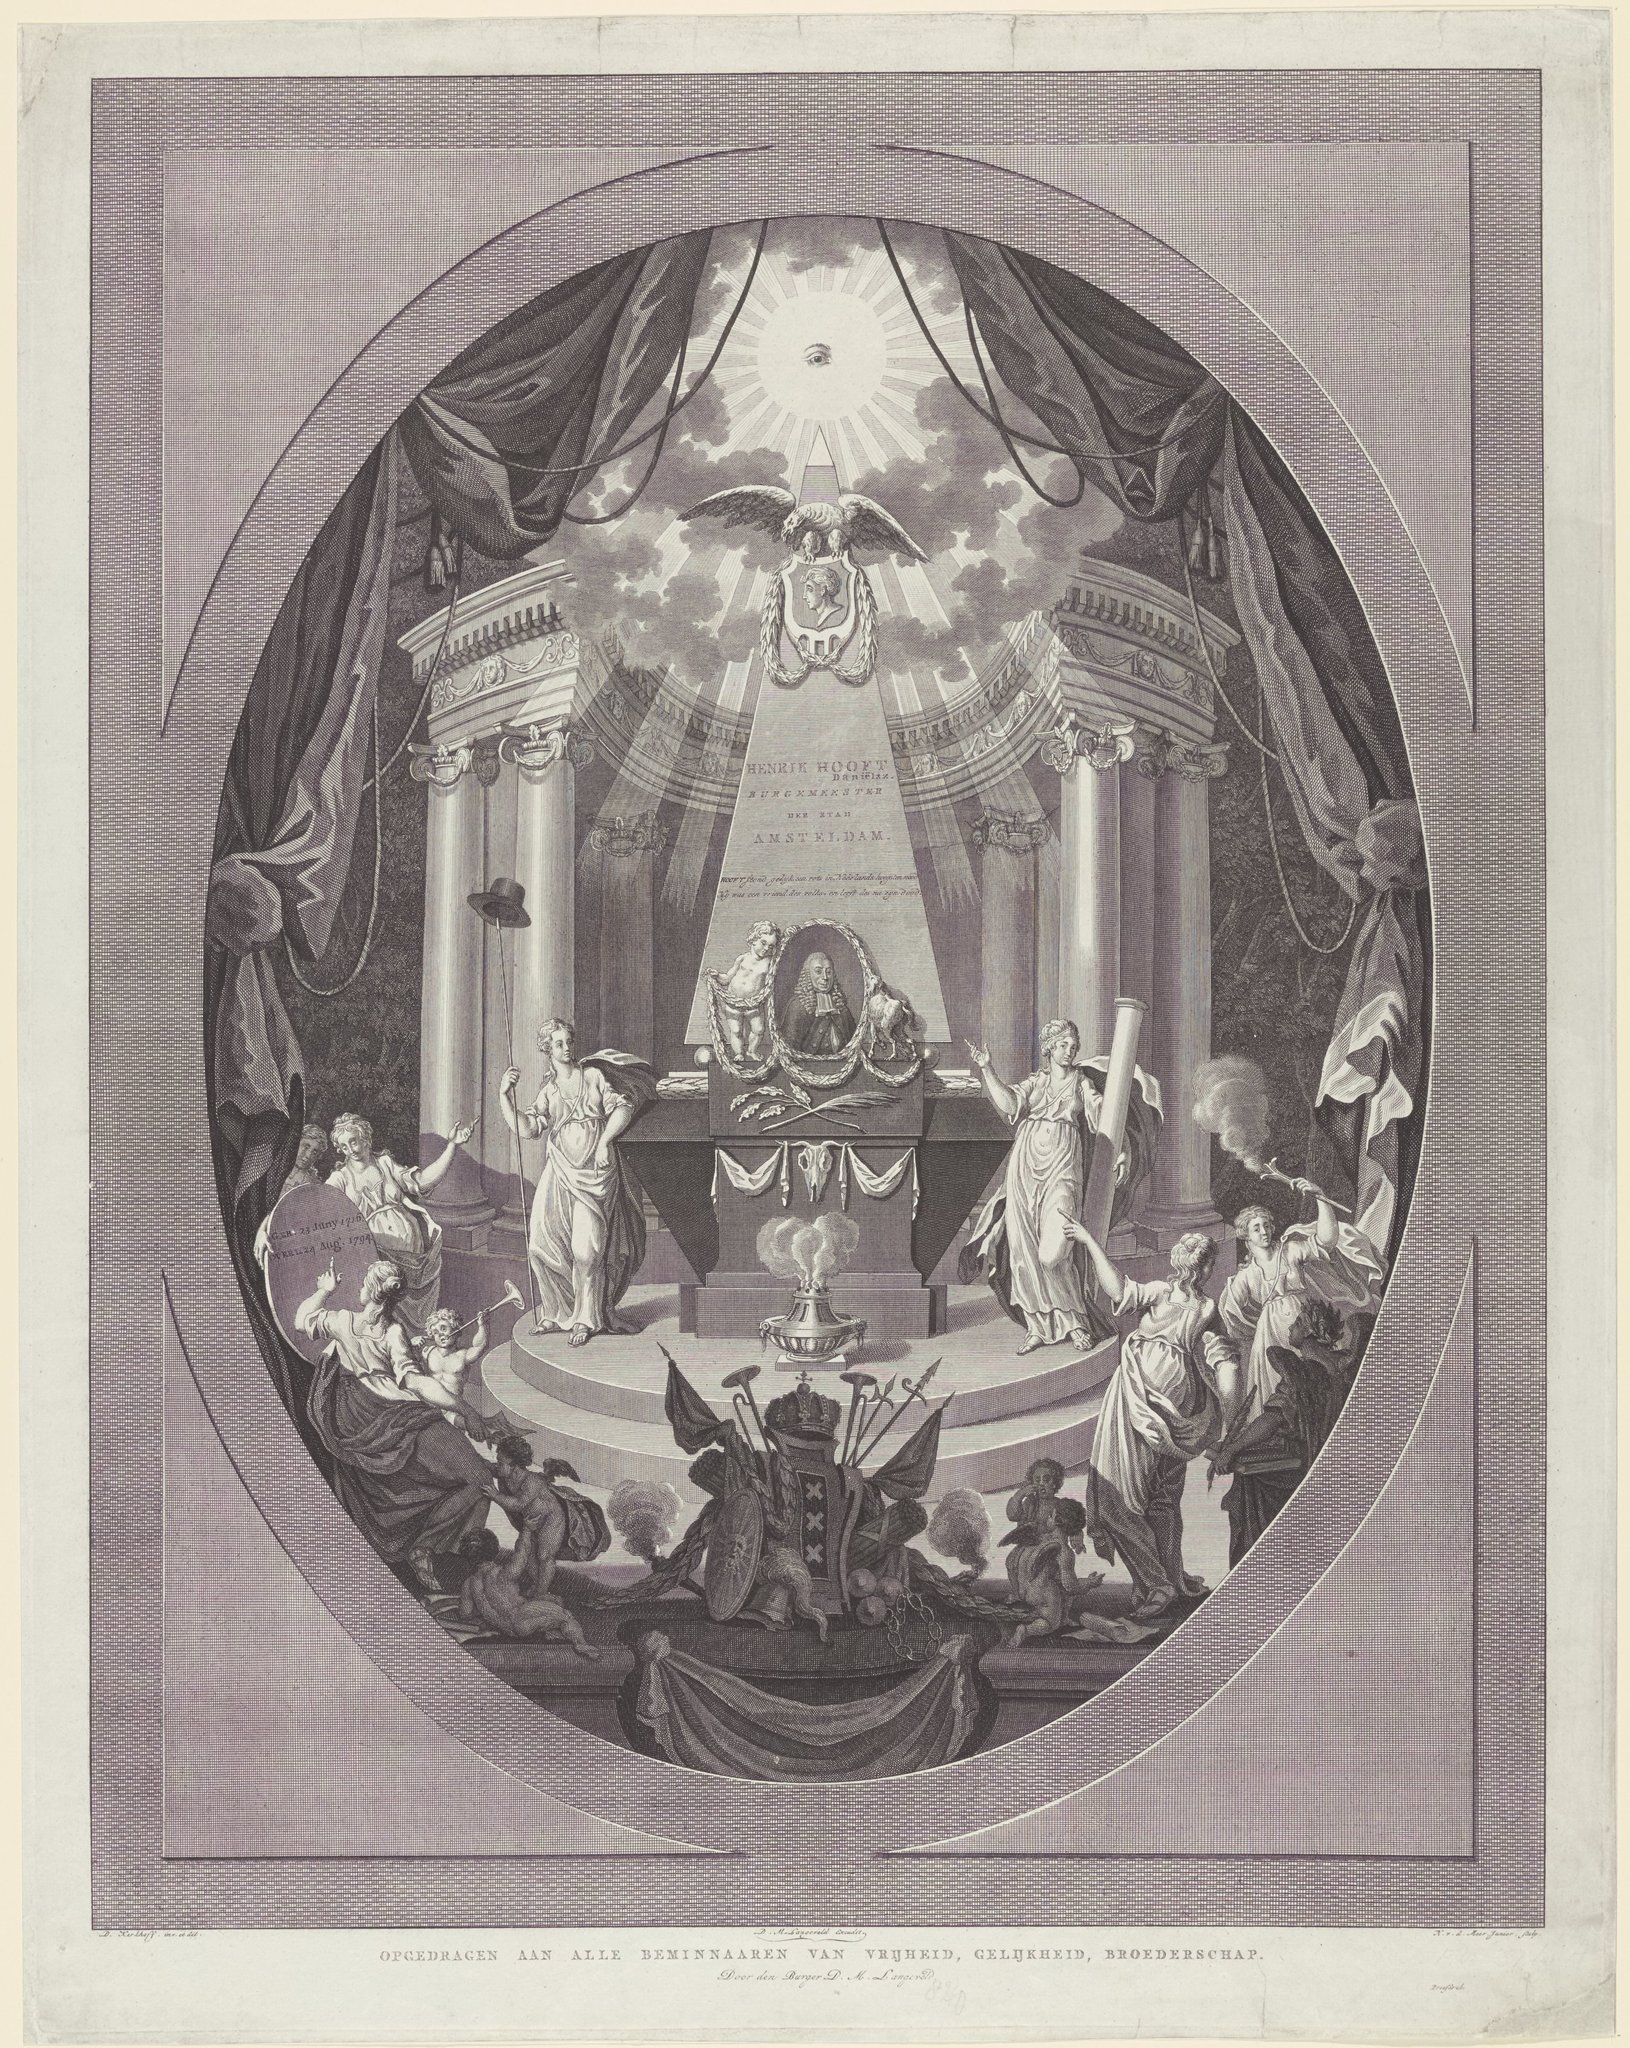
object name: print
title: Monument voor Hendrik Danielsz. Hooft, 1794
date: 1794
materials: paper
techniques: engraving, etching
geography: netherlands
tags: amsterdam, mayor, hendrik danielsz. hooft, fortitude, 'fortitudo' ~ one of the four cardinal virtues, the all-seeing eye, triangle with eye ~ symbol of god the father, grave-building, monumental tomb, freedom, liberty; 'libertà' (ripa) (+ abstract concept represented by female figure)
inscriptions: collector's mark: Lugt 2228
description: Ovale voorstelling van een allegorisch grafmonument voor Hendrik Danielsz. Hooft, oud-burgemeester van Amsterdam, overleden op 31 augustus 1794. Voor een piramide in een tempel het portret van Hooft, aan weerszijden staan de Vrijheid en de Standvastigheid. Op de voorgrond een trofee met het stadswapen van Amsterdam en meerdere allegorische figuren. In de wolken het Alziende Oog.